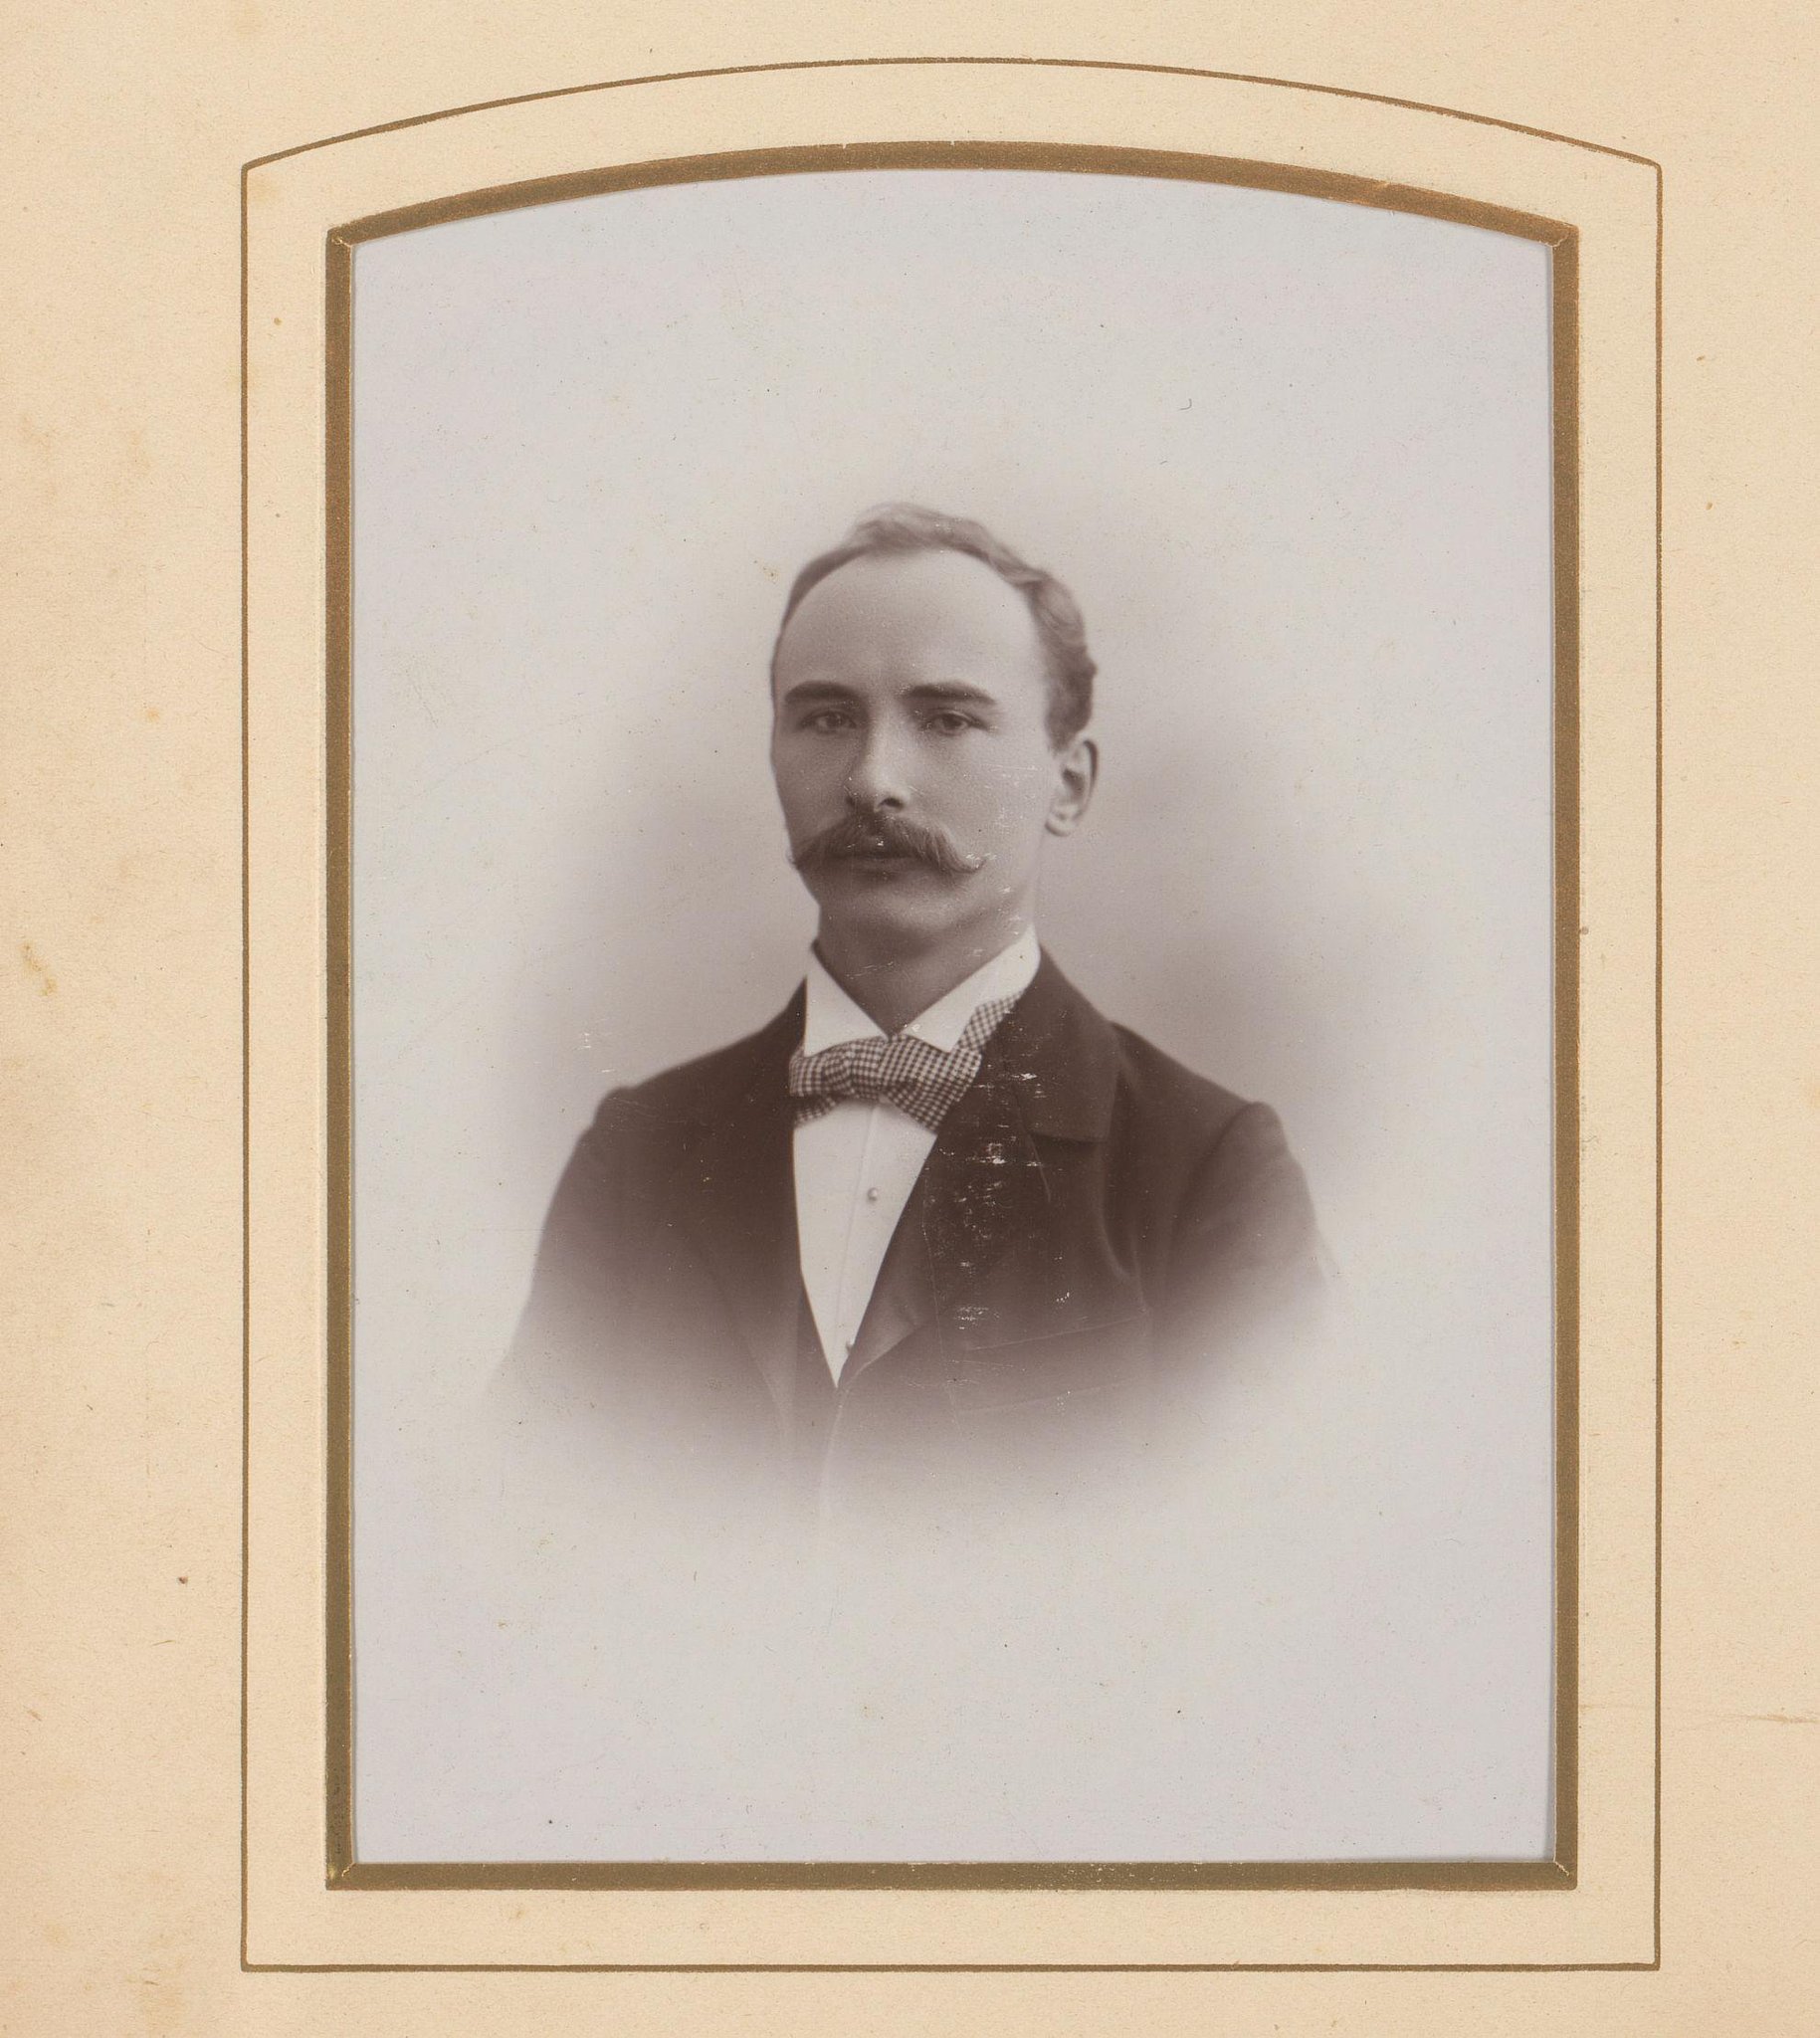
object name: cabinet photograph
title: Portret van een man met snor en vlinderstrik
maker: machiel hendricus laddé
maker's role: fotograaf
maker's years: 1866-1932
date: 1899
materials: cardboard, photographic support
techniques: collodion silver print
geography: amsterdam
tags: historical persons, beard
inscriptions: inscription: ‘No. .../ [...]grafie/ [...]/ Het Cliche wordt [...]tellingen bewaard.’, inscription: ‘M.H. Laddé/ Nieuwendijk 57-59, Amsterdam’, date: ‘1899’